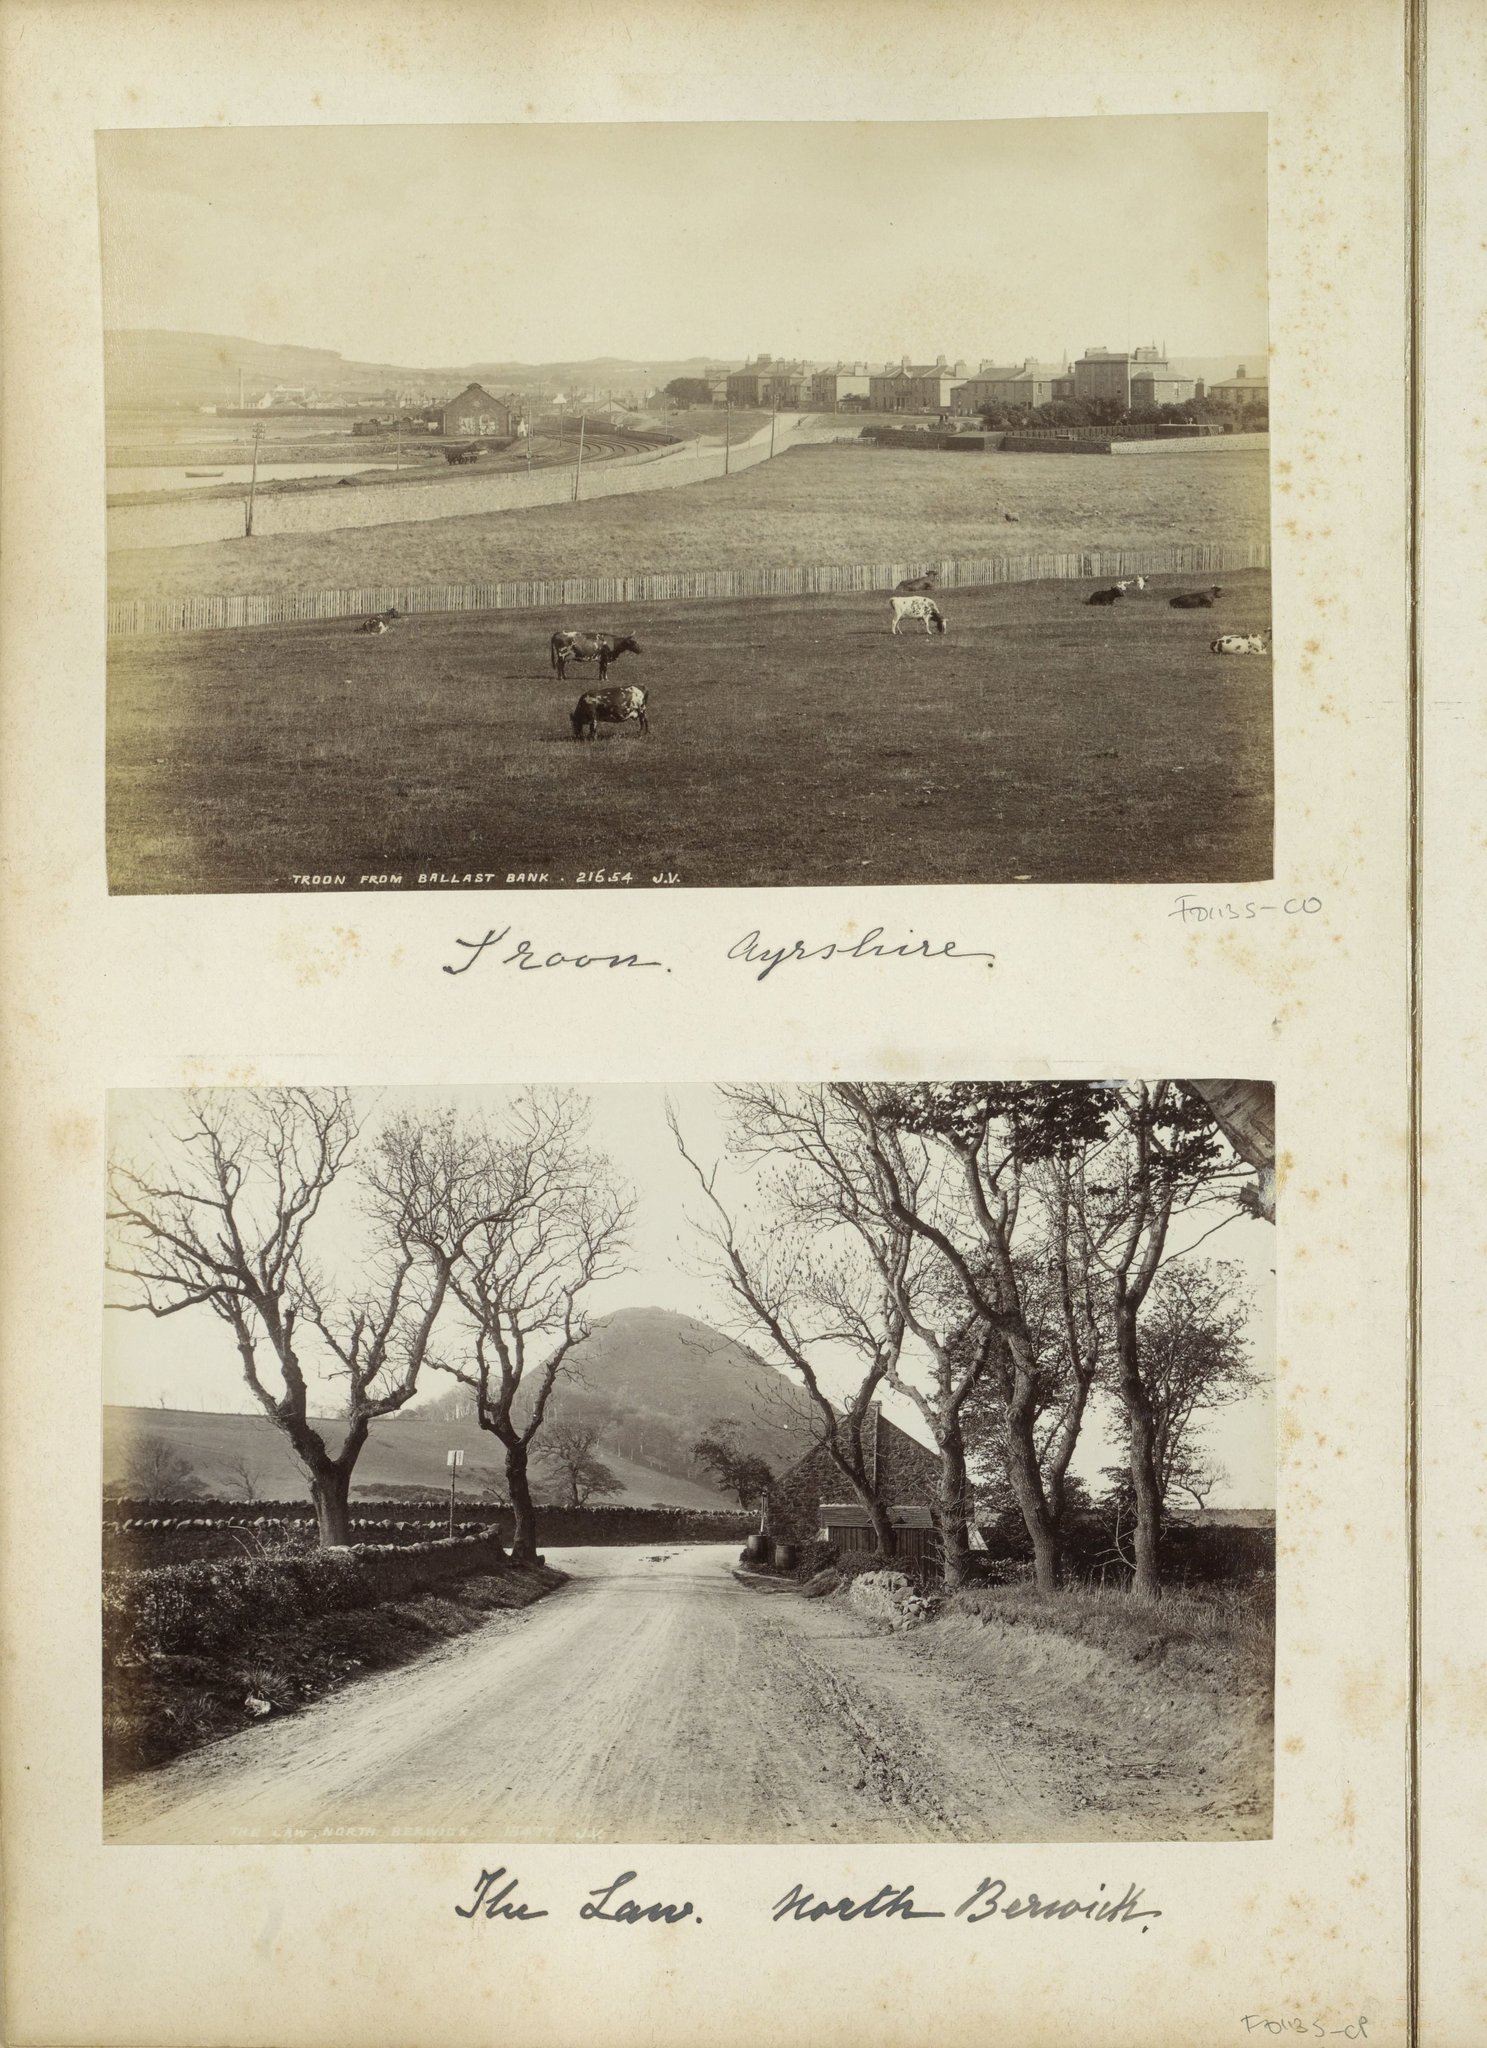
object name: photograph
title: Laan in North Berwick met aan het einde de heuvel The Law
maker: james valentine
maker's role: fotograaf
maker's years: 1815-1880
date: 1900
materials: paper, photographic support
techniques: albumen print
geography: north berwick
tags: (high) hill, lane, alley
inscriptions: negative number: ‘18477’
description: Onderdeel van Reisalbum met foto's van bezienswaardigheden in Engeland en Frankrijk.